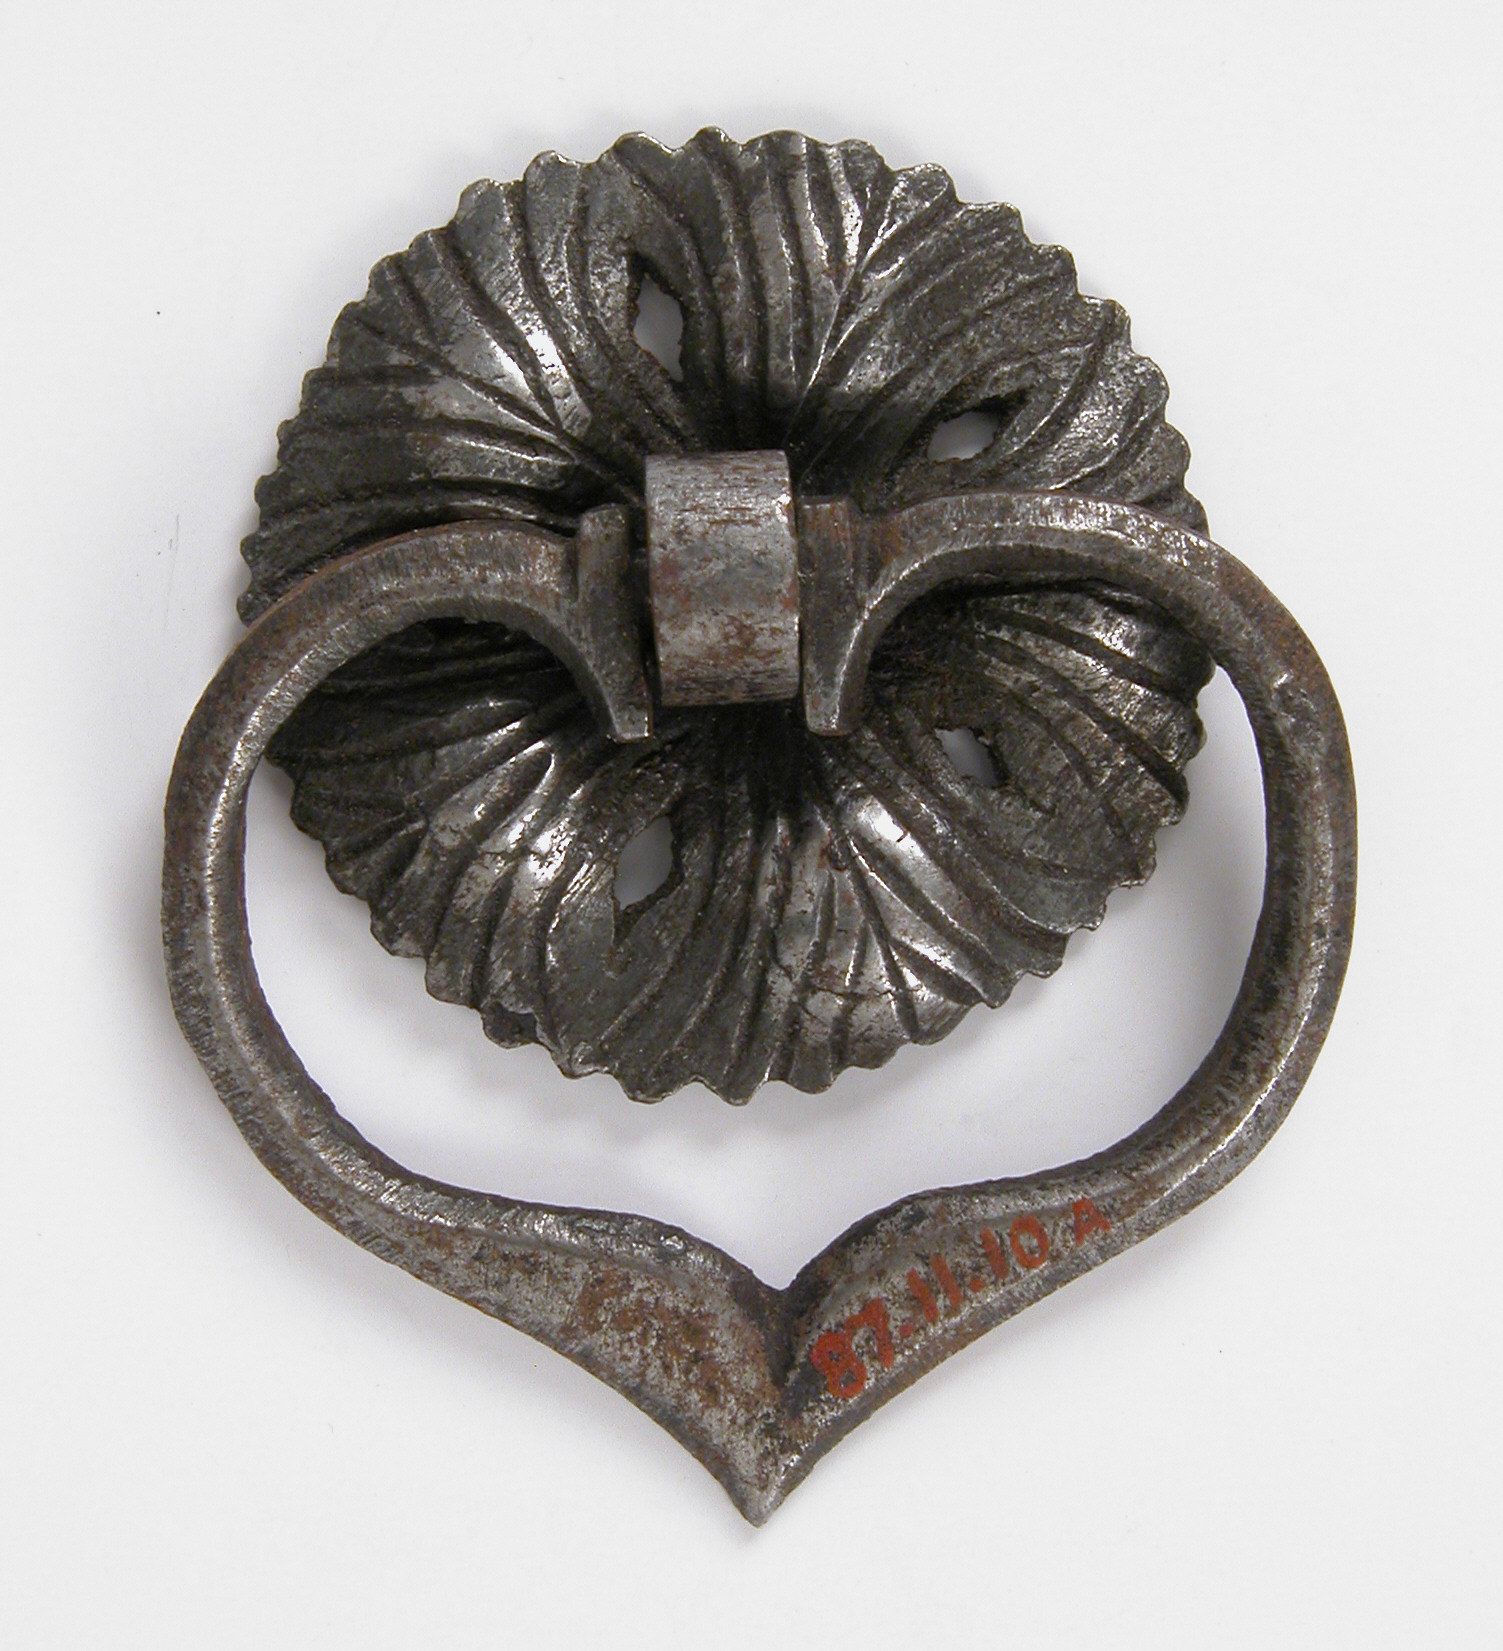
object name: door handle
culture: german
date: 1401-1600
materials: iron